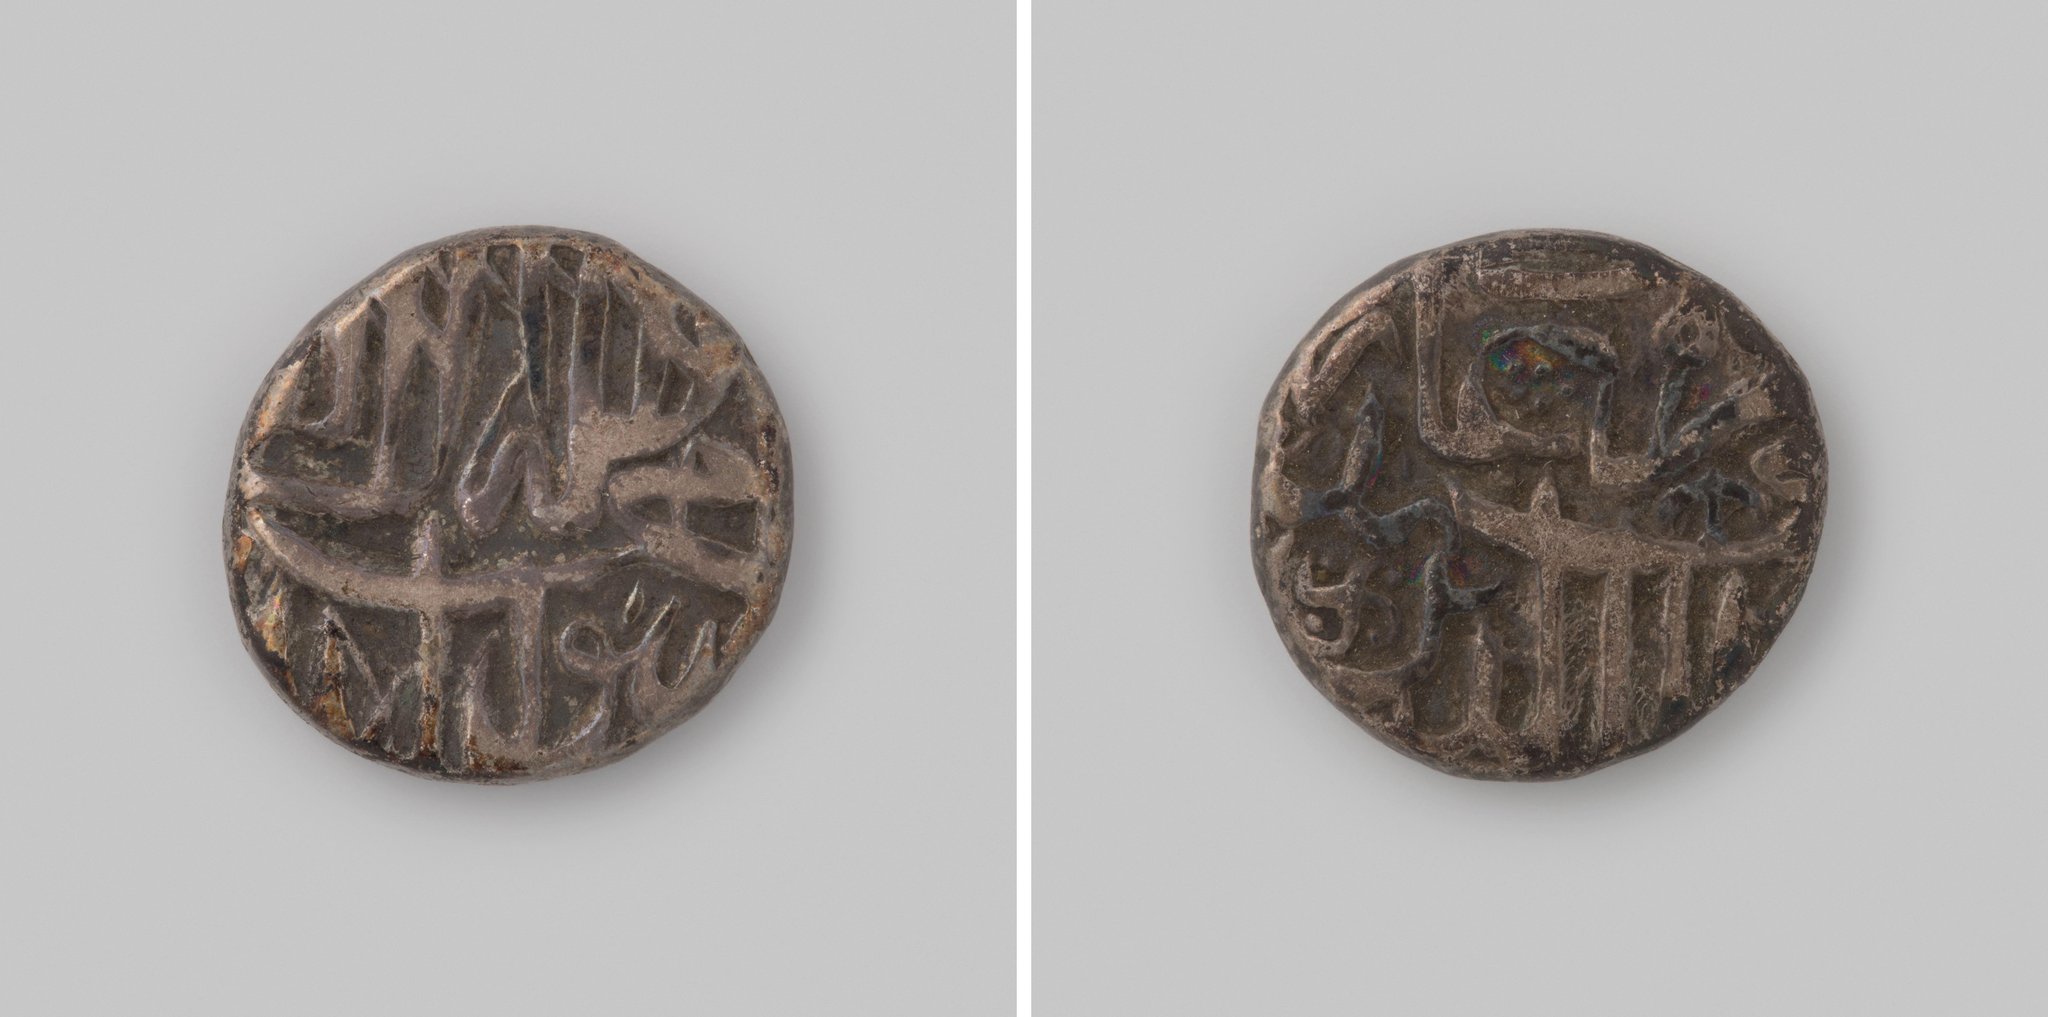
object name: coin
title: India, Mohammed Akbar I, 963-1014 [=1555-1605], ½ roepie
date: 1555-1605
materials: copper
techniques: striking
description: Koperen munt. Voorzijde: in Arabische lettertekens opschrift in drie regels. Keerzijde: in Arabische lettertekens in drie regels opschrift. Opschriften zijn onvolledig, de munt is zwaar gesnoeid.